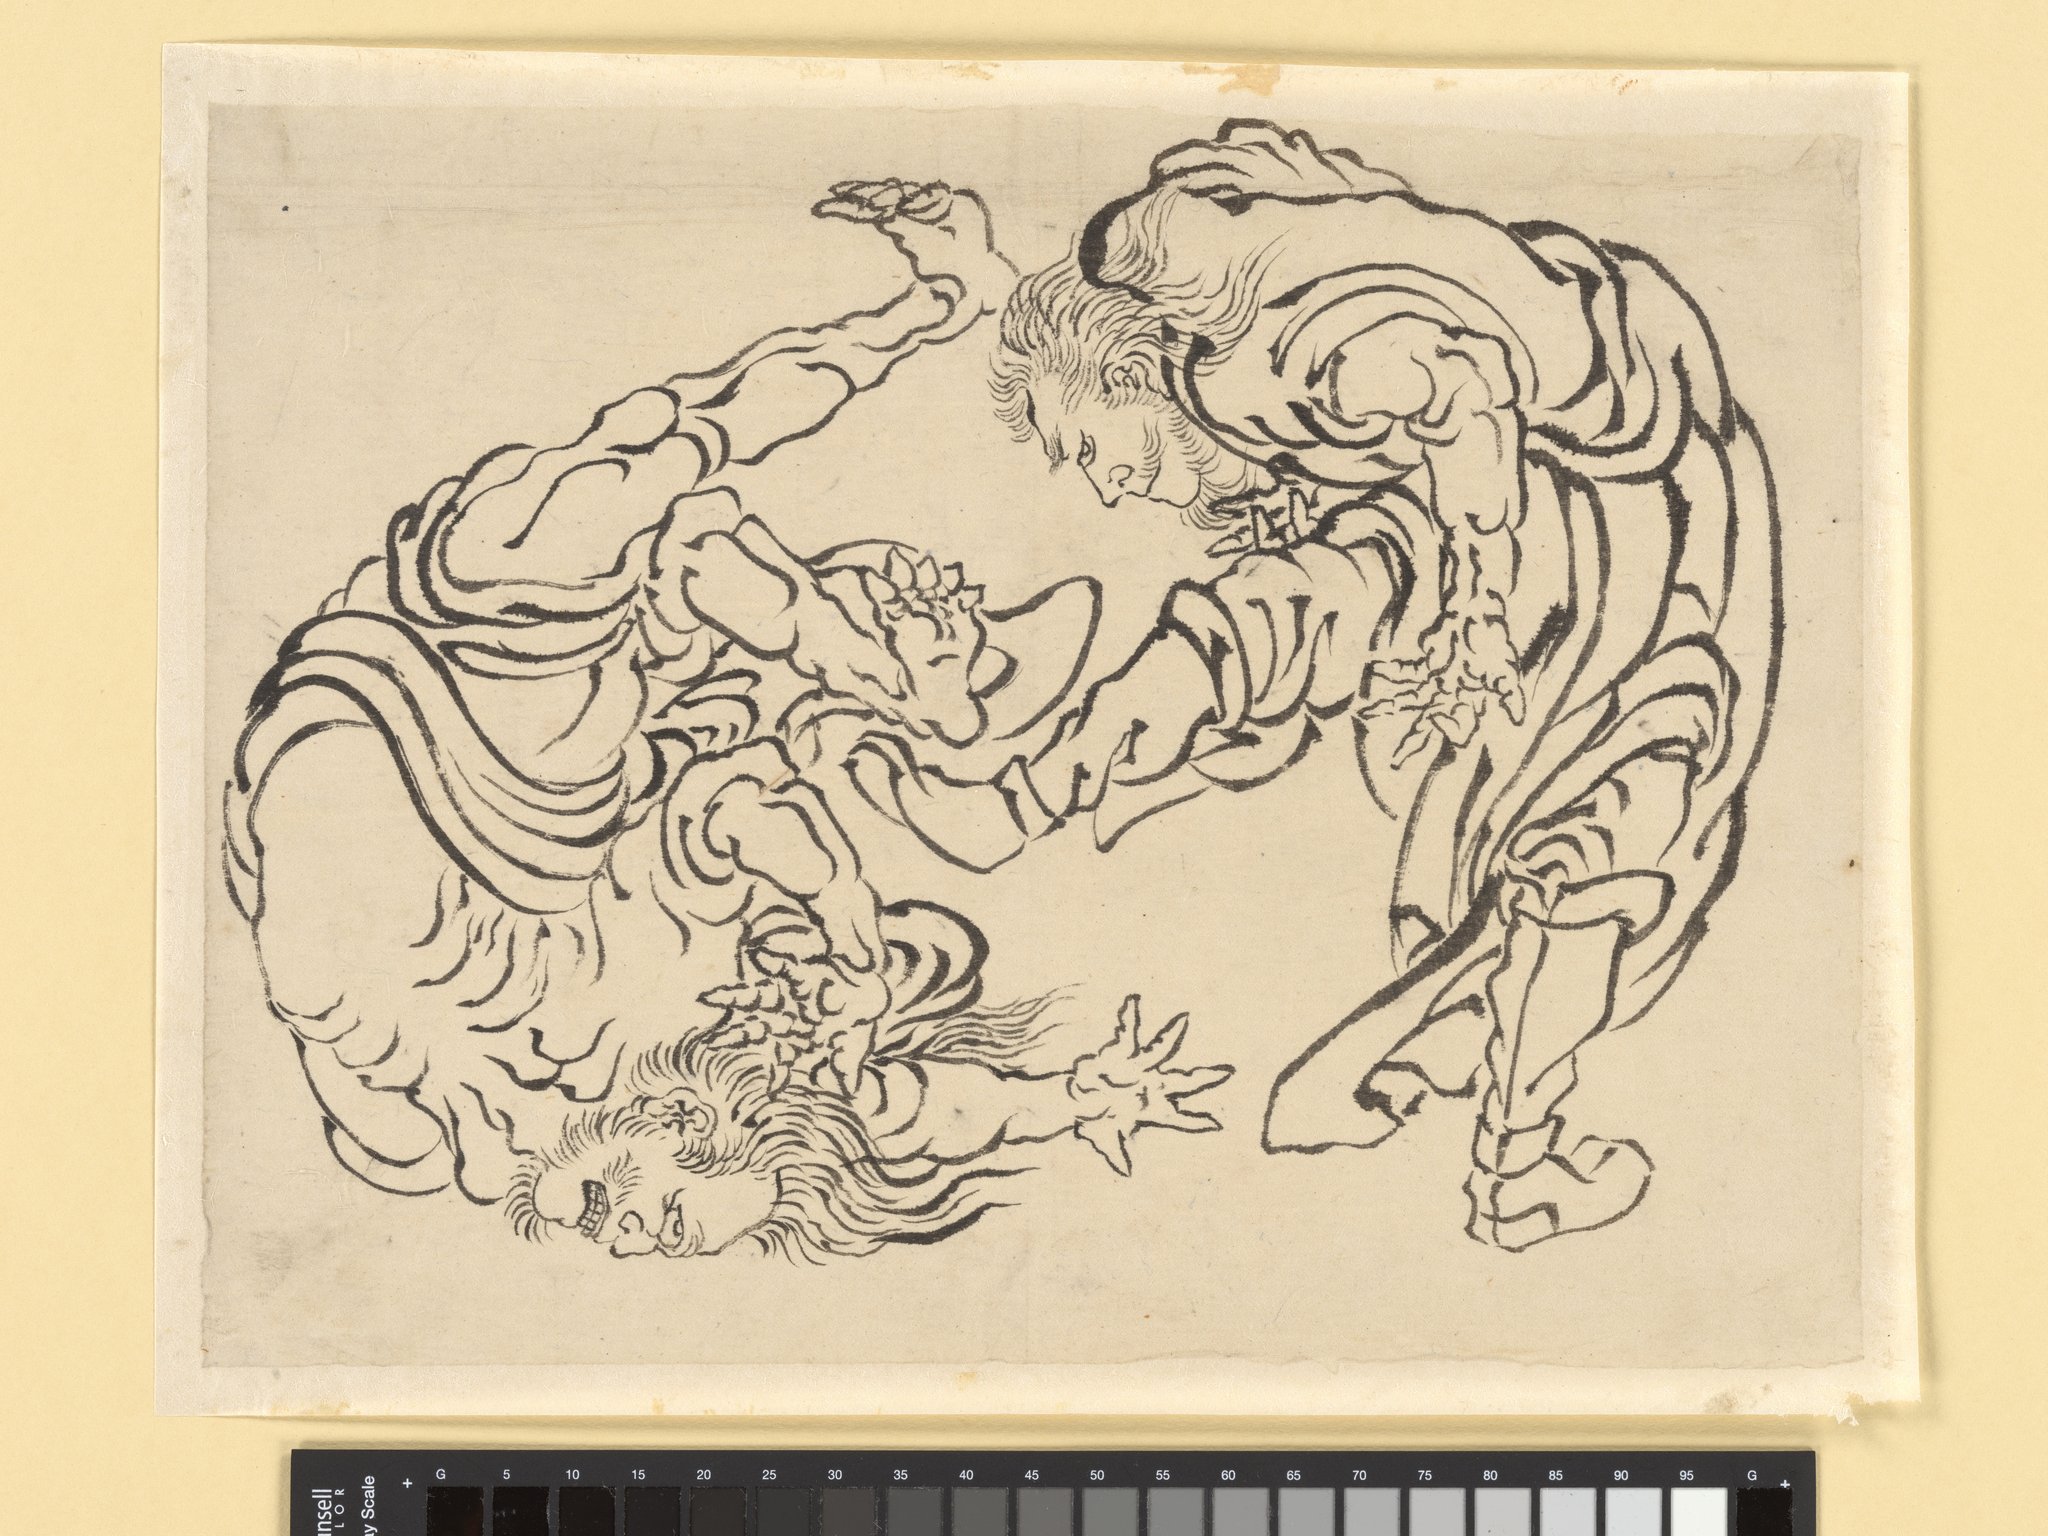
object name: drawing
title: Two Wrestlers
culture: japanese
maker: katsushika hokusai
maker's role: artist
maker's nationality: japanese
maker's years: 1760-1849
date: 1701-1900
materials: ink, paper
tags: men,wrestling